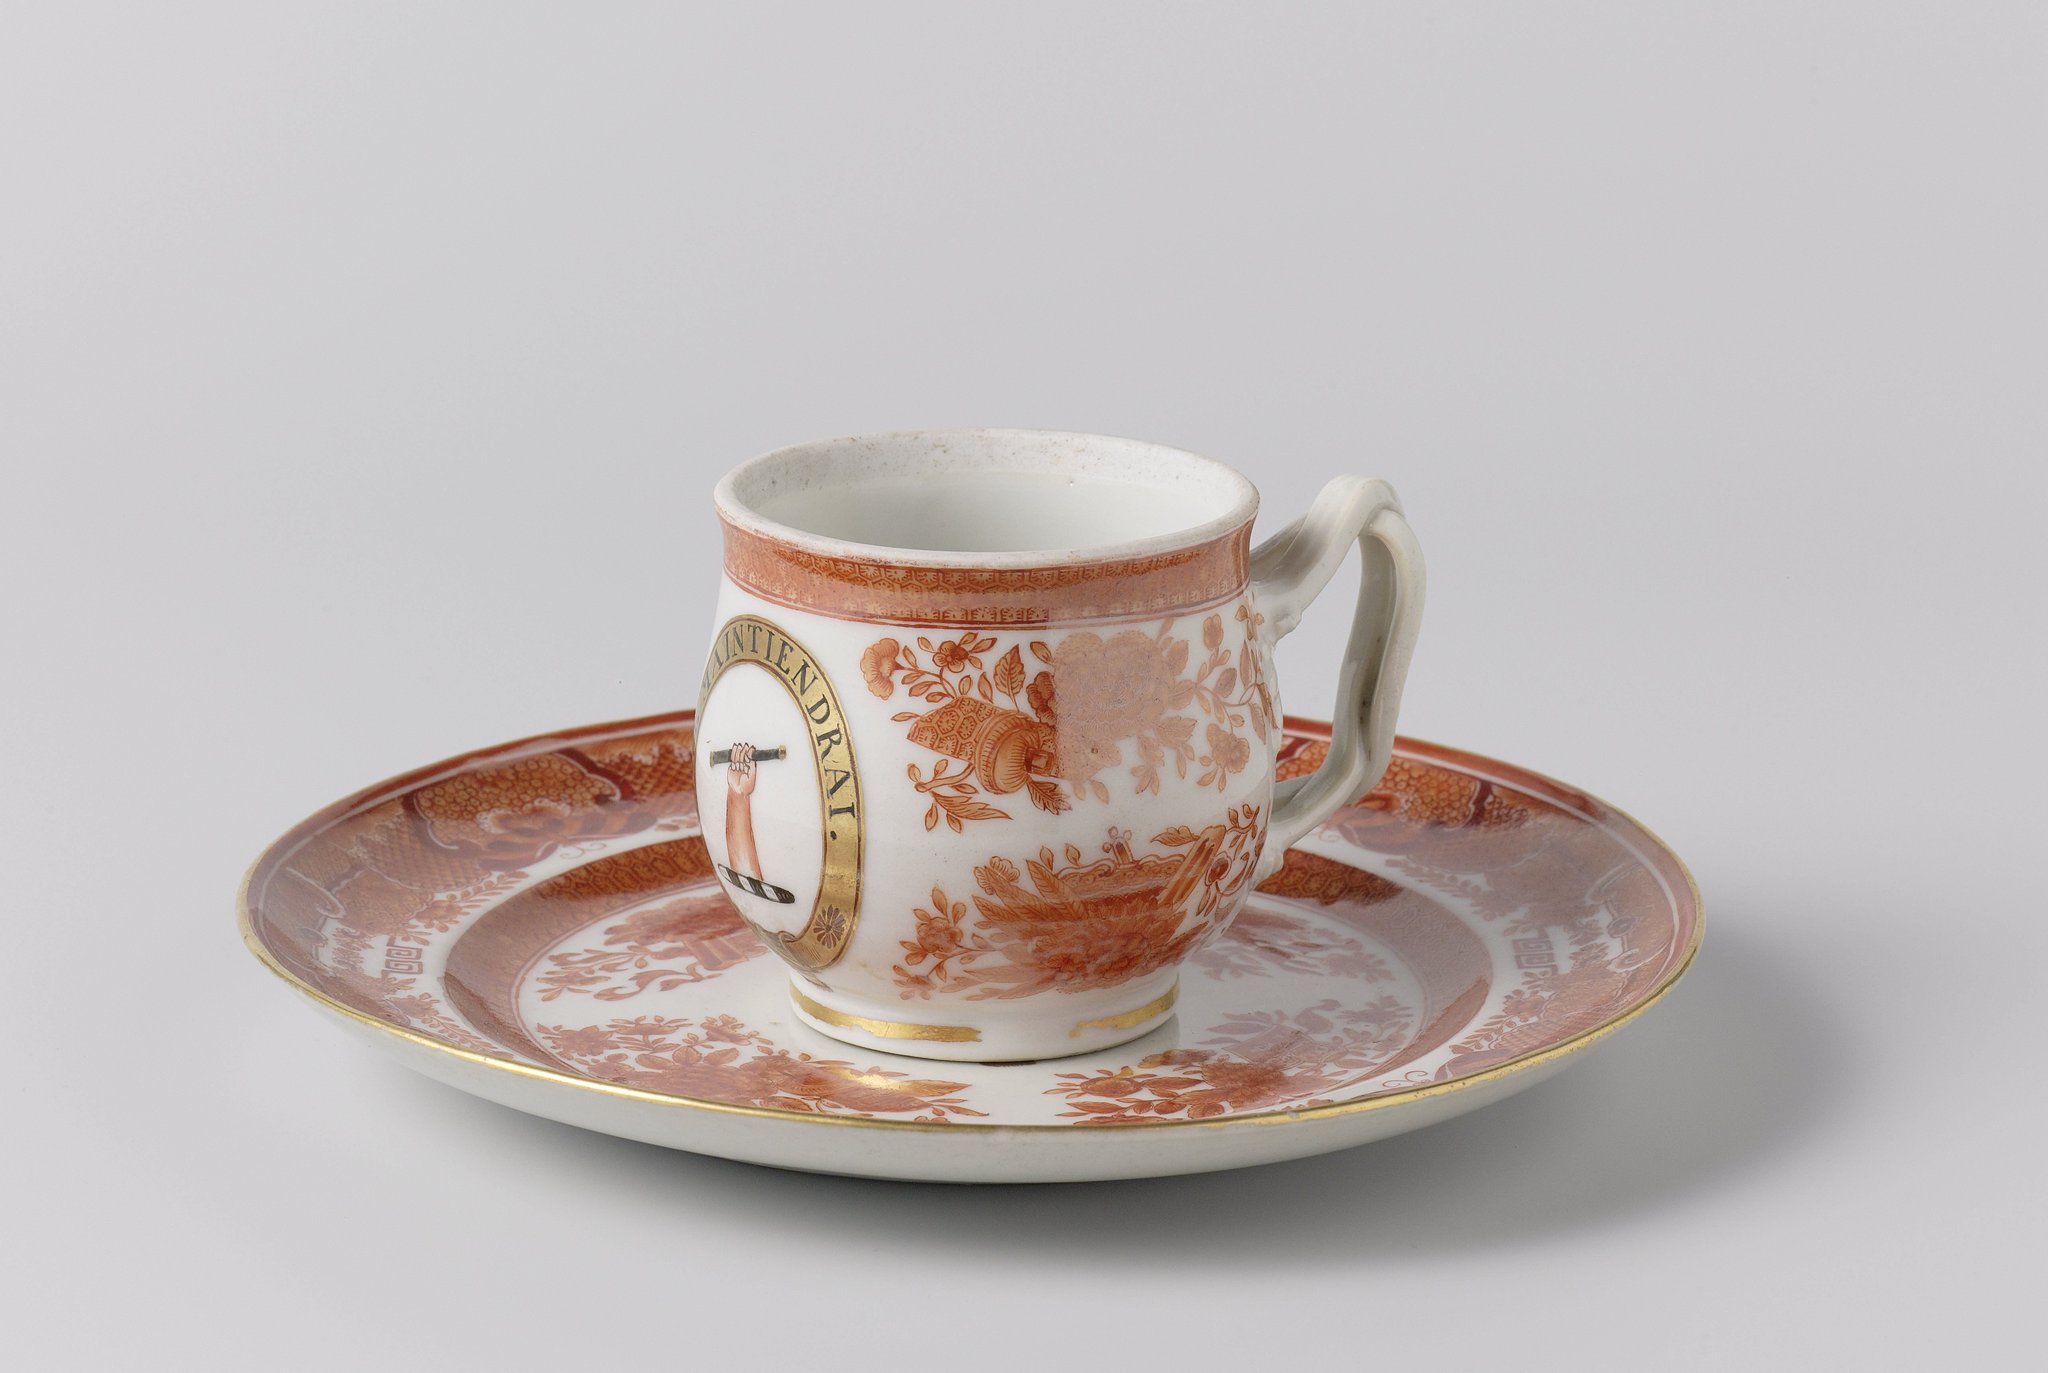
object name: covered cup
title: Covered cup with a coat of arms, flower sprays and auspicious symbols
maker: Anonymous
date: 1775-1799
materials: glaze, gold, paint, porcelain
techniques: firing, gilding, turning, vitrification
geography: china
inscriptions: inscription: ‘JE LE MAINTIENDRAI’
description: Oorkop met deksel van porselein met bolvormig lichaam en gevlochten oor, beschilderd op het glazuur in rood, zwart en goud. Op de buitenwand een ongeïdentificeerd wapen met een hand die een staf vasthoudt tegen een witte achtergrond; om het wapen het opschrift 'JE LE MAINTIENDRAI'. Aan weerszijden van het wapen bloemtakken met gelukssymbolen. Op de buitenrand een band met servetwerk. Wapenporselein met emailkleuren.